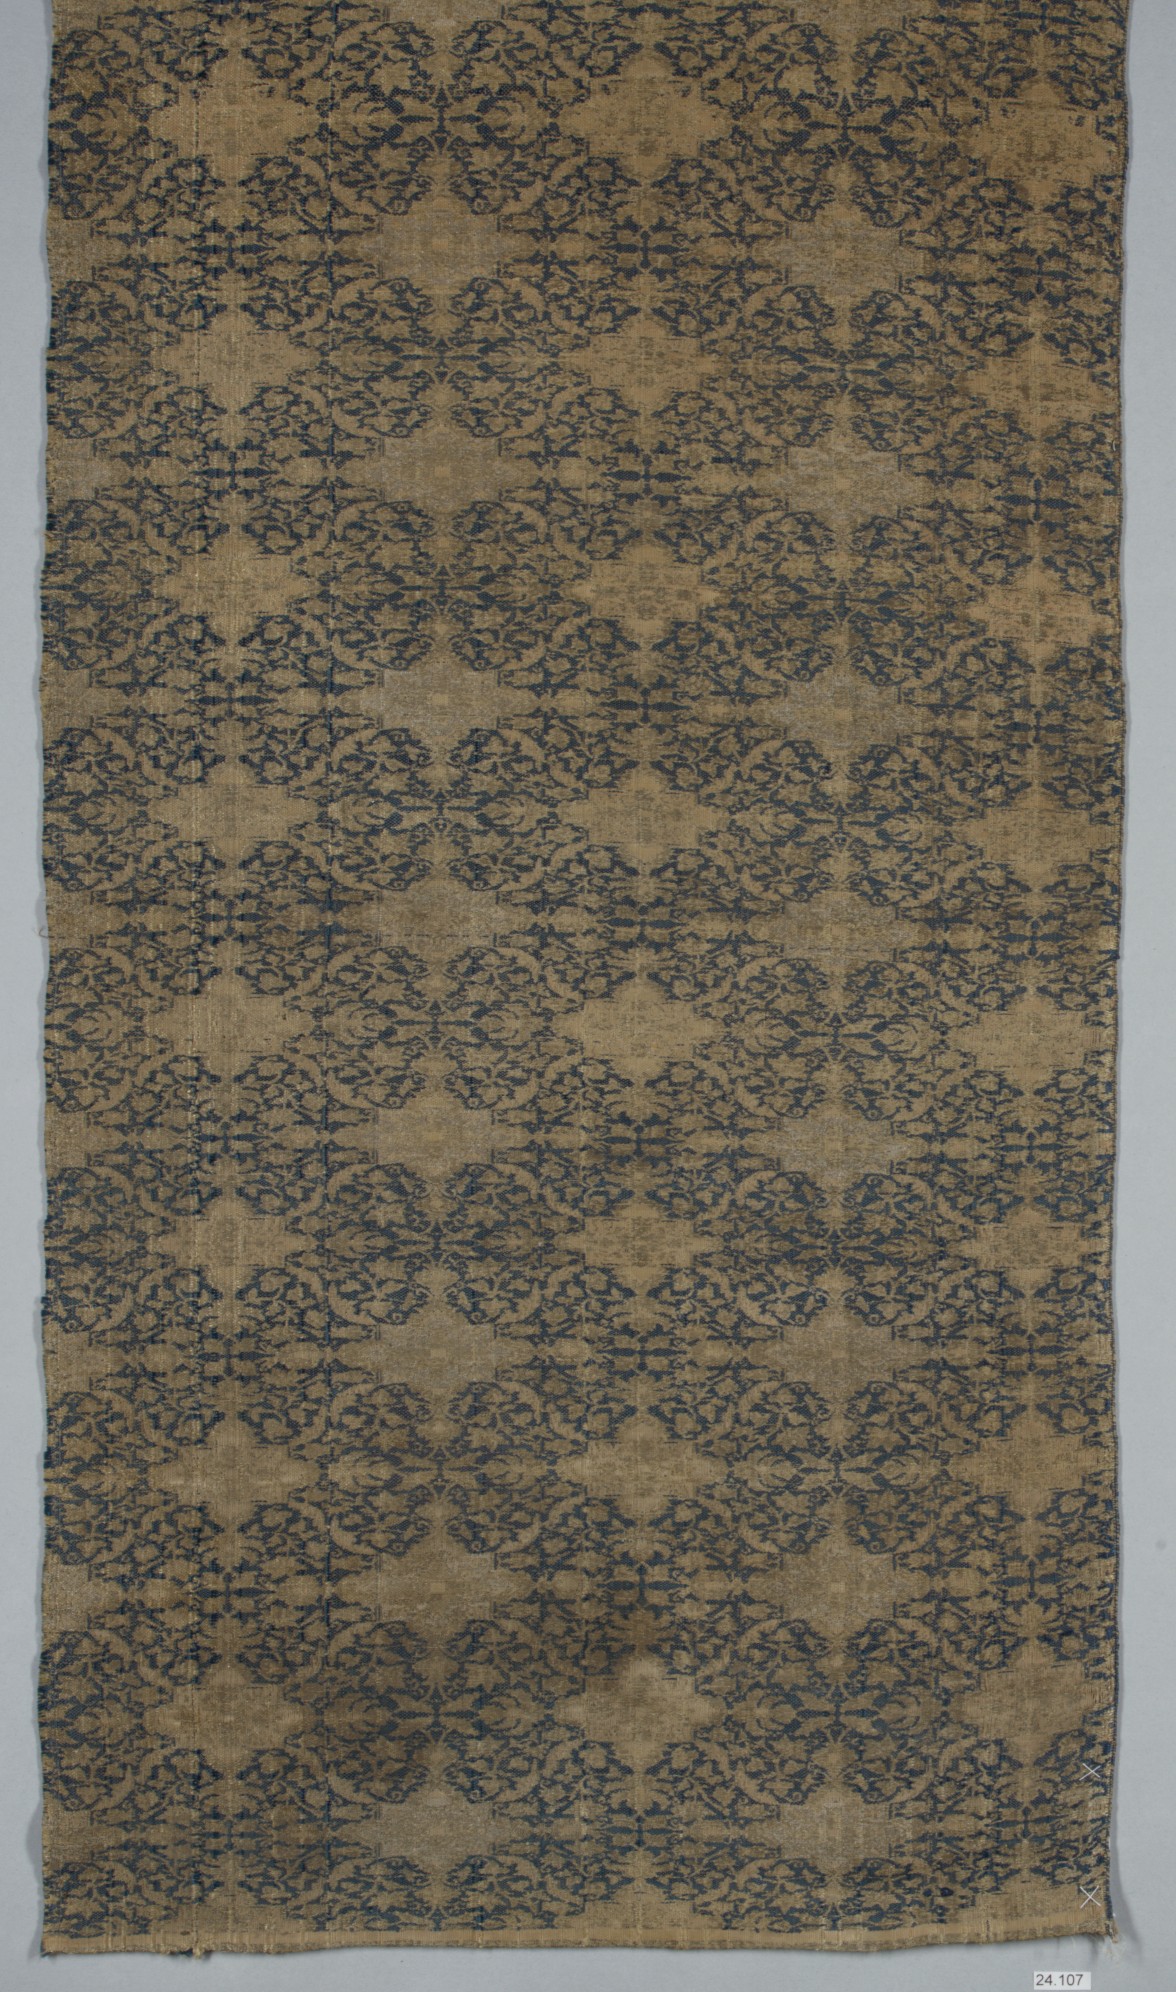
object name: brocade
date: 1601-1800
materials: metal thread, silk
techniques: brocade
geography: iran